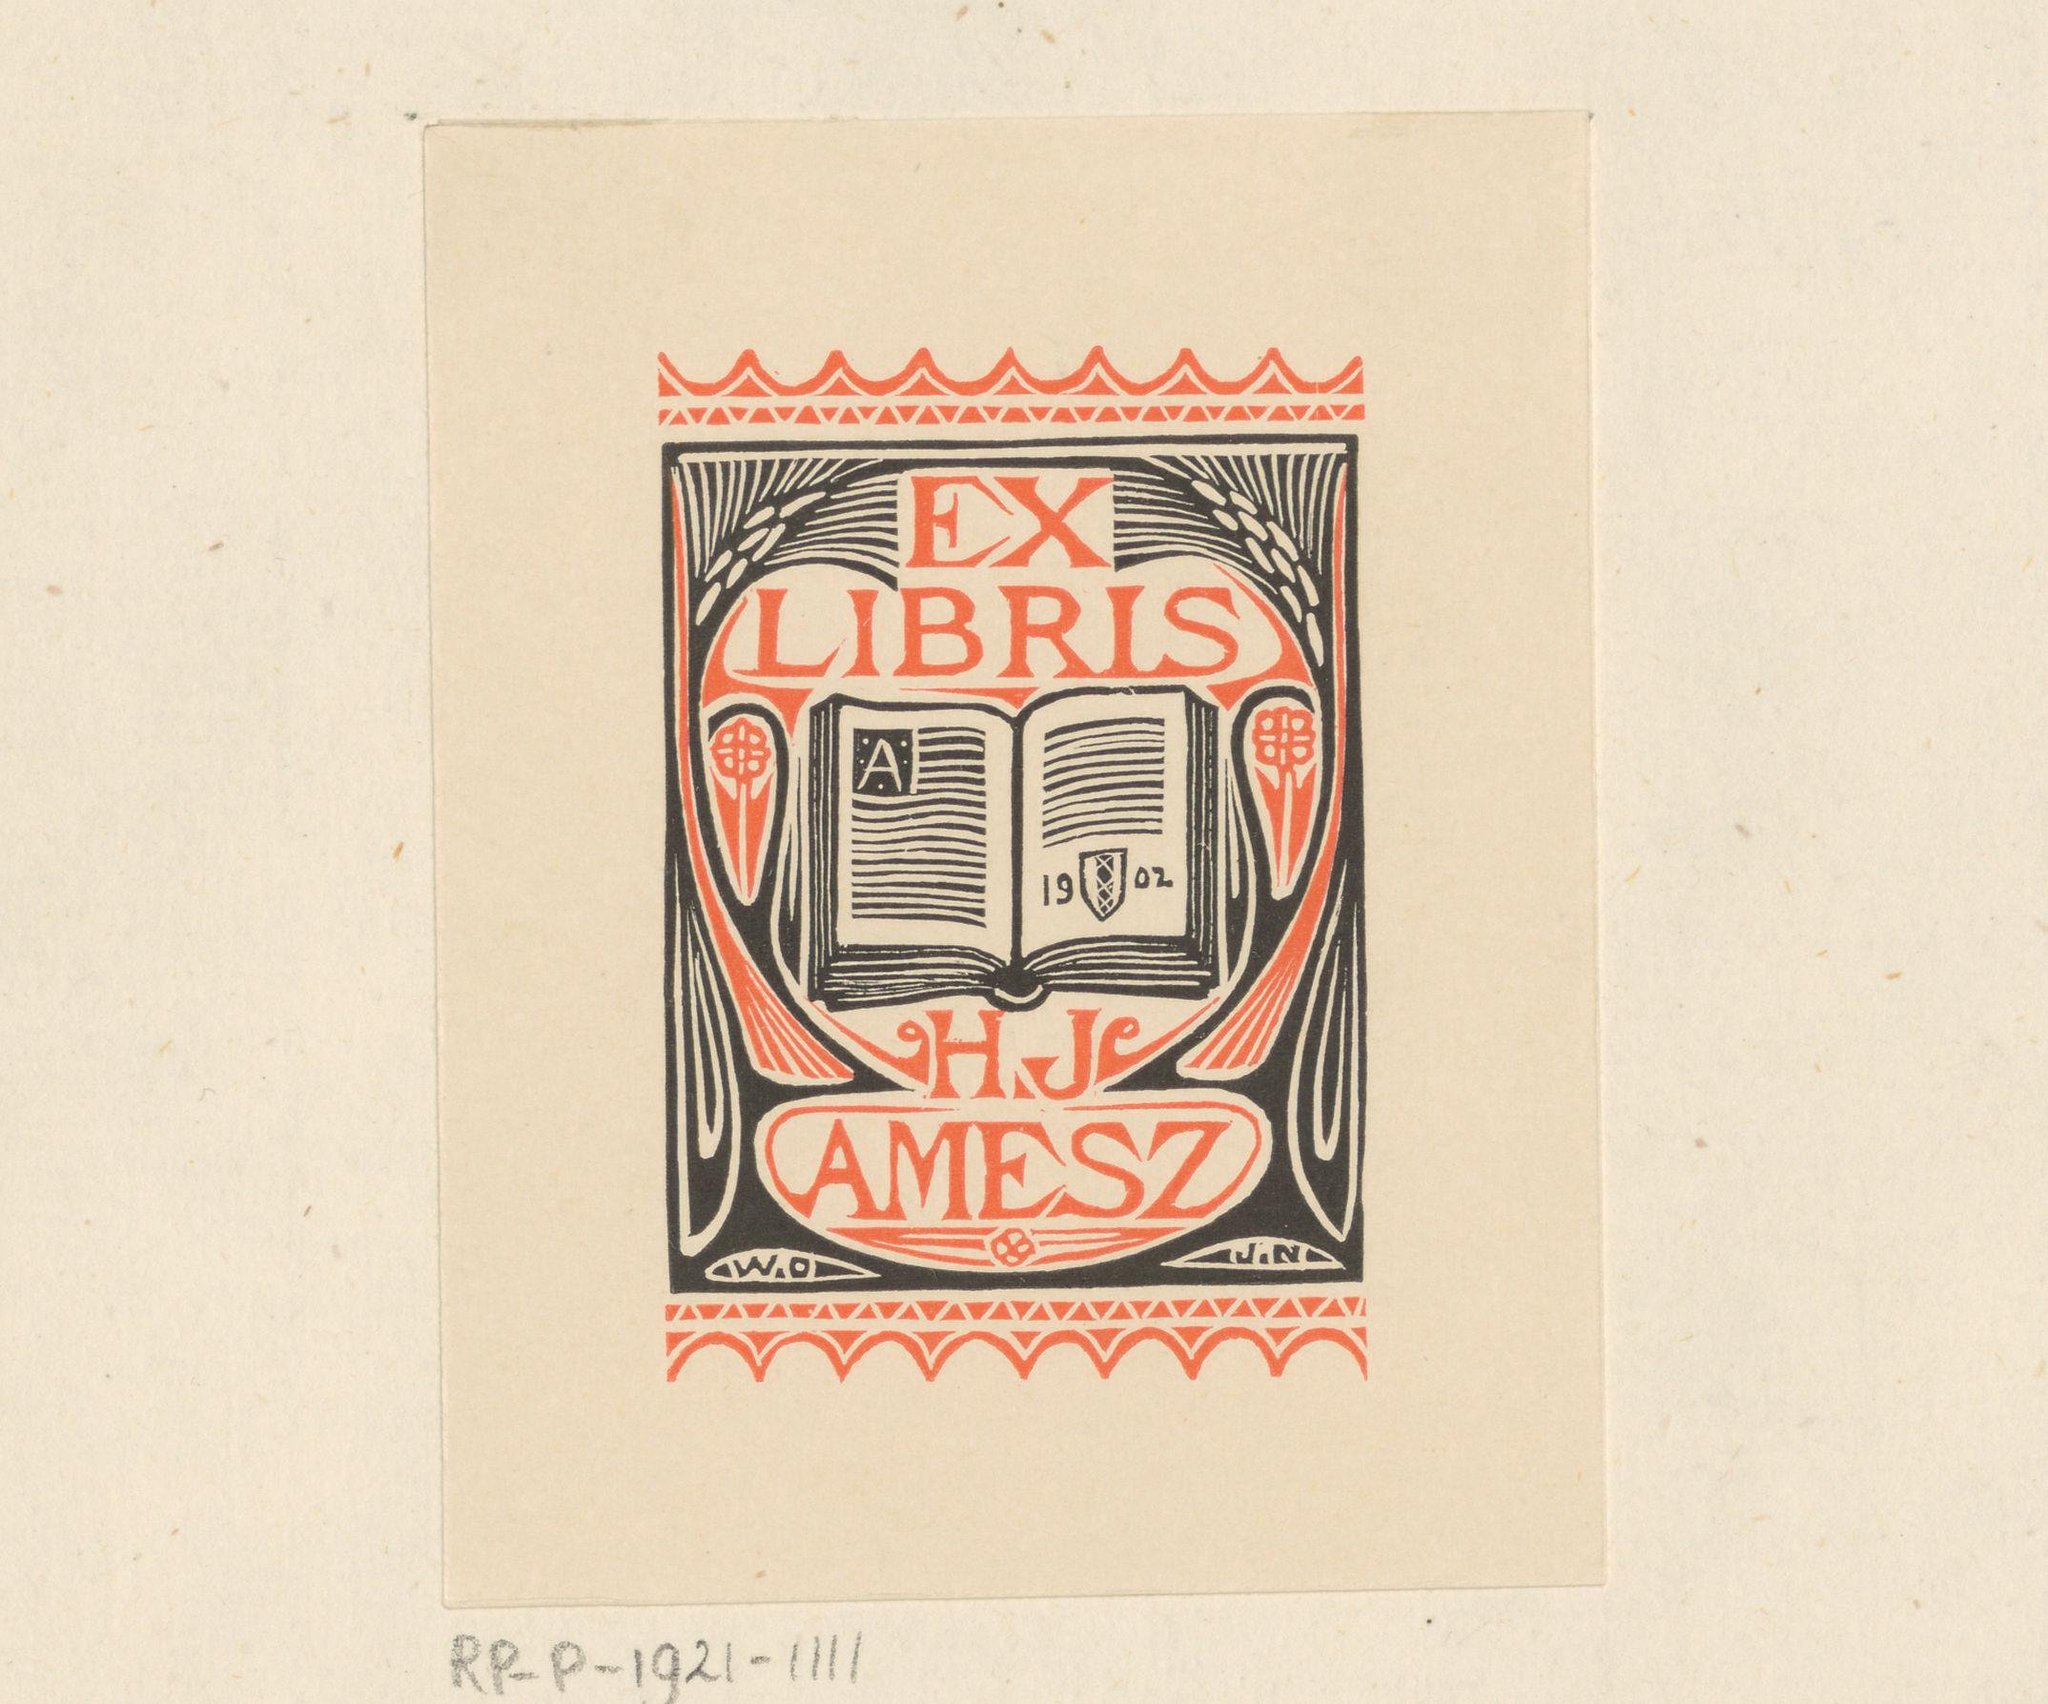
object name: bookplate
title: Ex libris van H.J. Amesz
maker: wijnand otto jan nieuwenkamp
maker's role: draughtsman, print maker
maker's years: 1874-1950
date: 1902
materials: paper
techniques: woodcut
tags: book - mm - book open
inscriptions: collector's mark: Lugt 2233